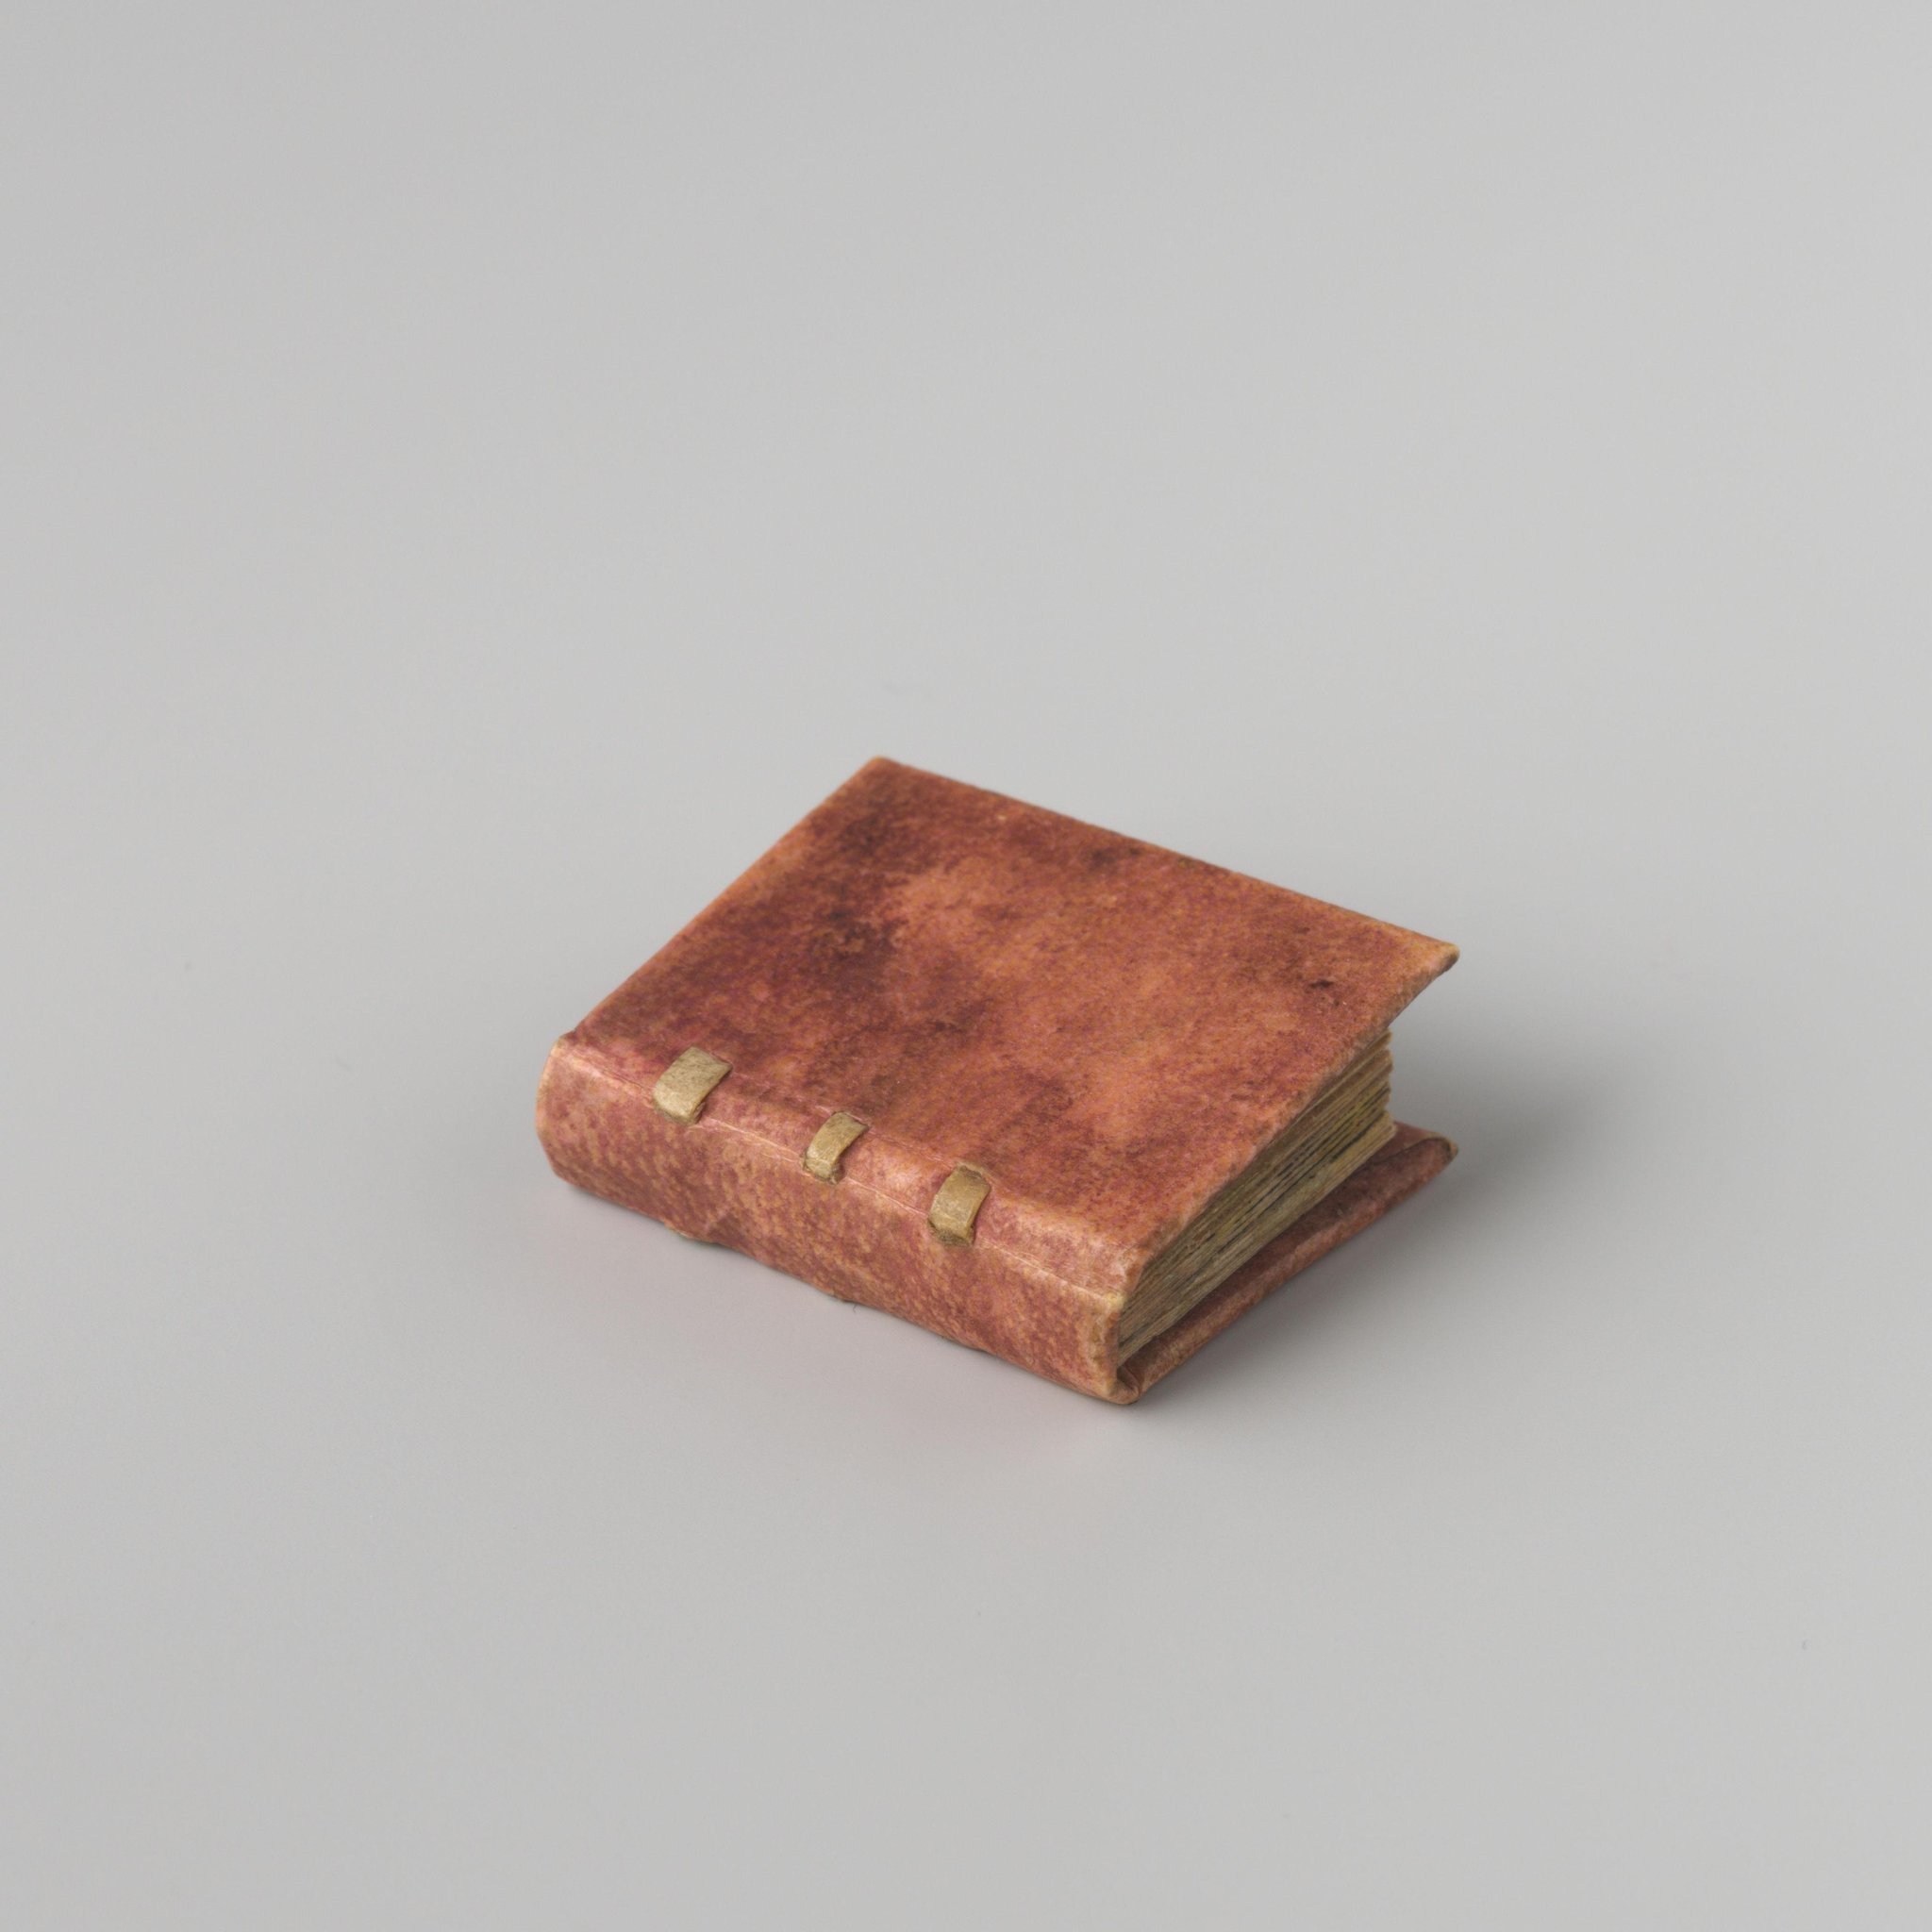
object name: book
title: Boek met stads- en tuingezichten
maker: Anonymous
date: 1690-1710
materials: paper, parchment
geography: amsterdam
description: Boek met stads- en tuingezichten. Ingebonden in roze gekleurd perkament.